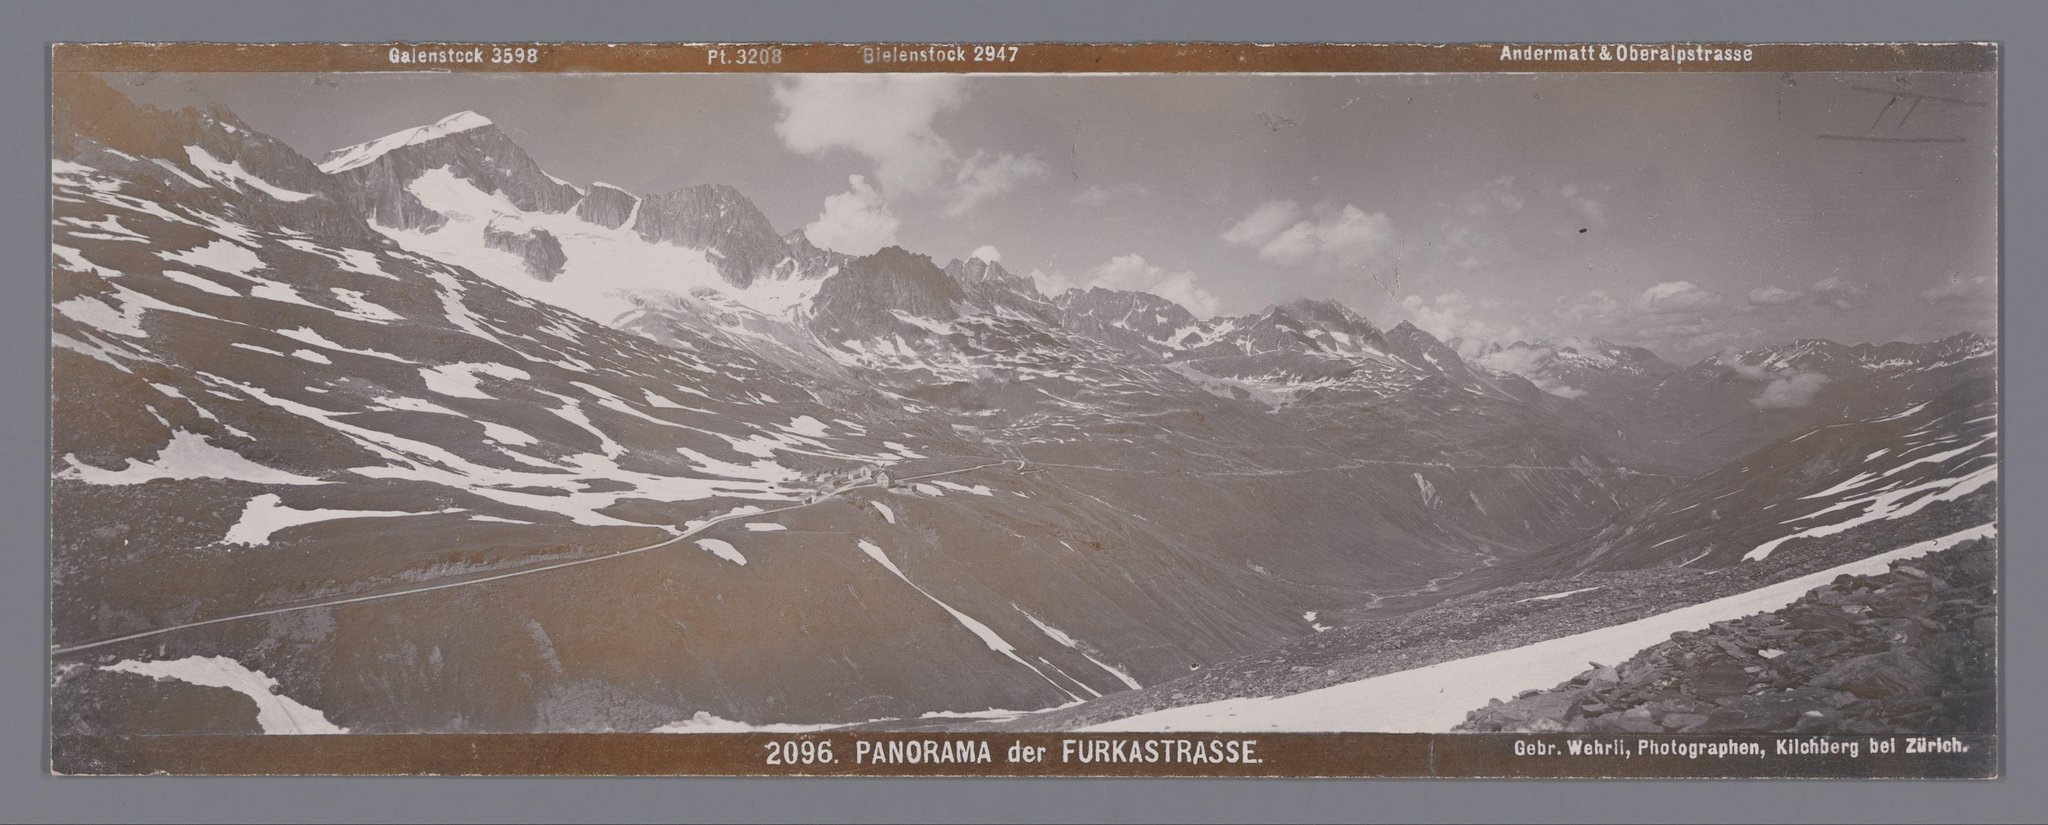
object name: panoramic photograph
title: Gezicht op de Furkapas en de Berner Alpen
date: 1897-1924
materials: paper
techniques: gelatin silver print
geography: berner alpen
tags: mountains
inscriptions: number: ‘2096.’, inscription: ‘Galenstock 3598 Pt. 3208 Bielenstock 2947 Andermatt & Oberalpstrasse’